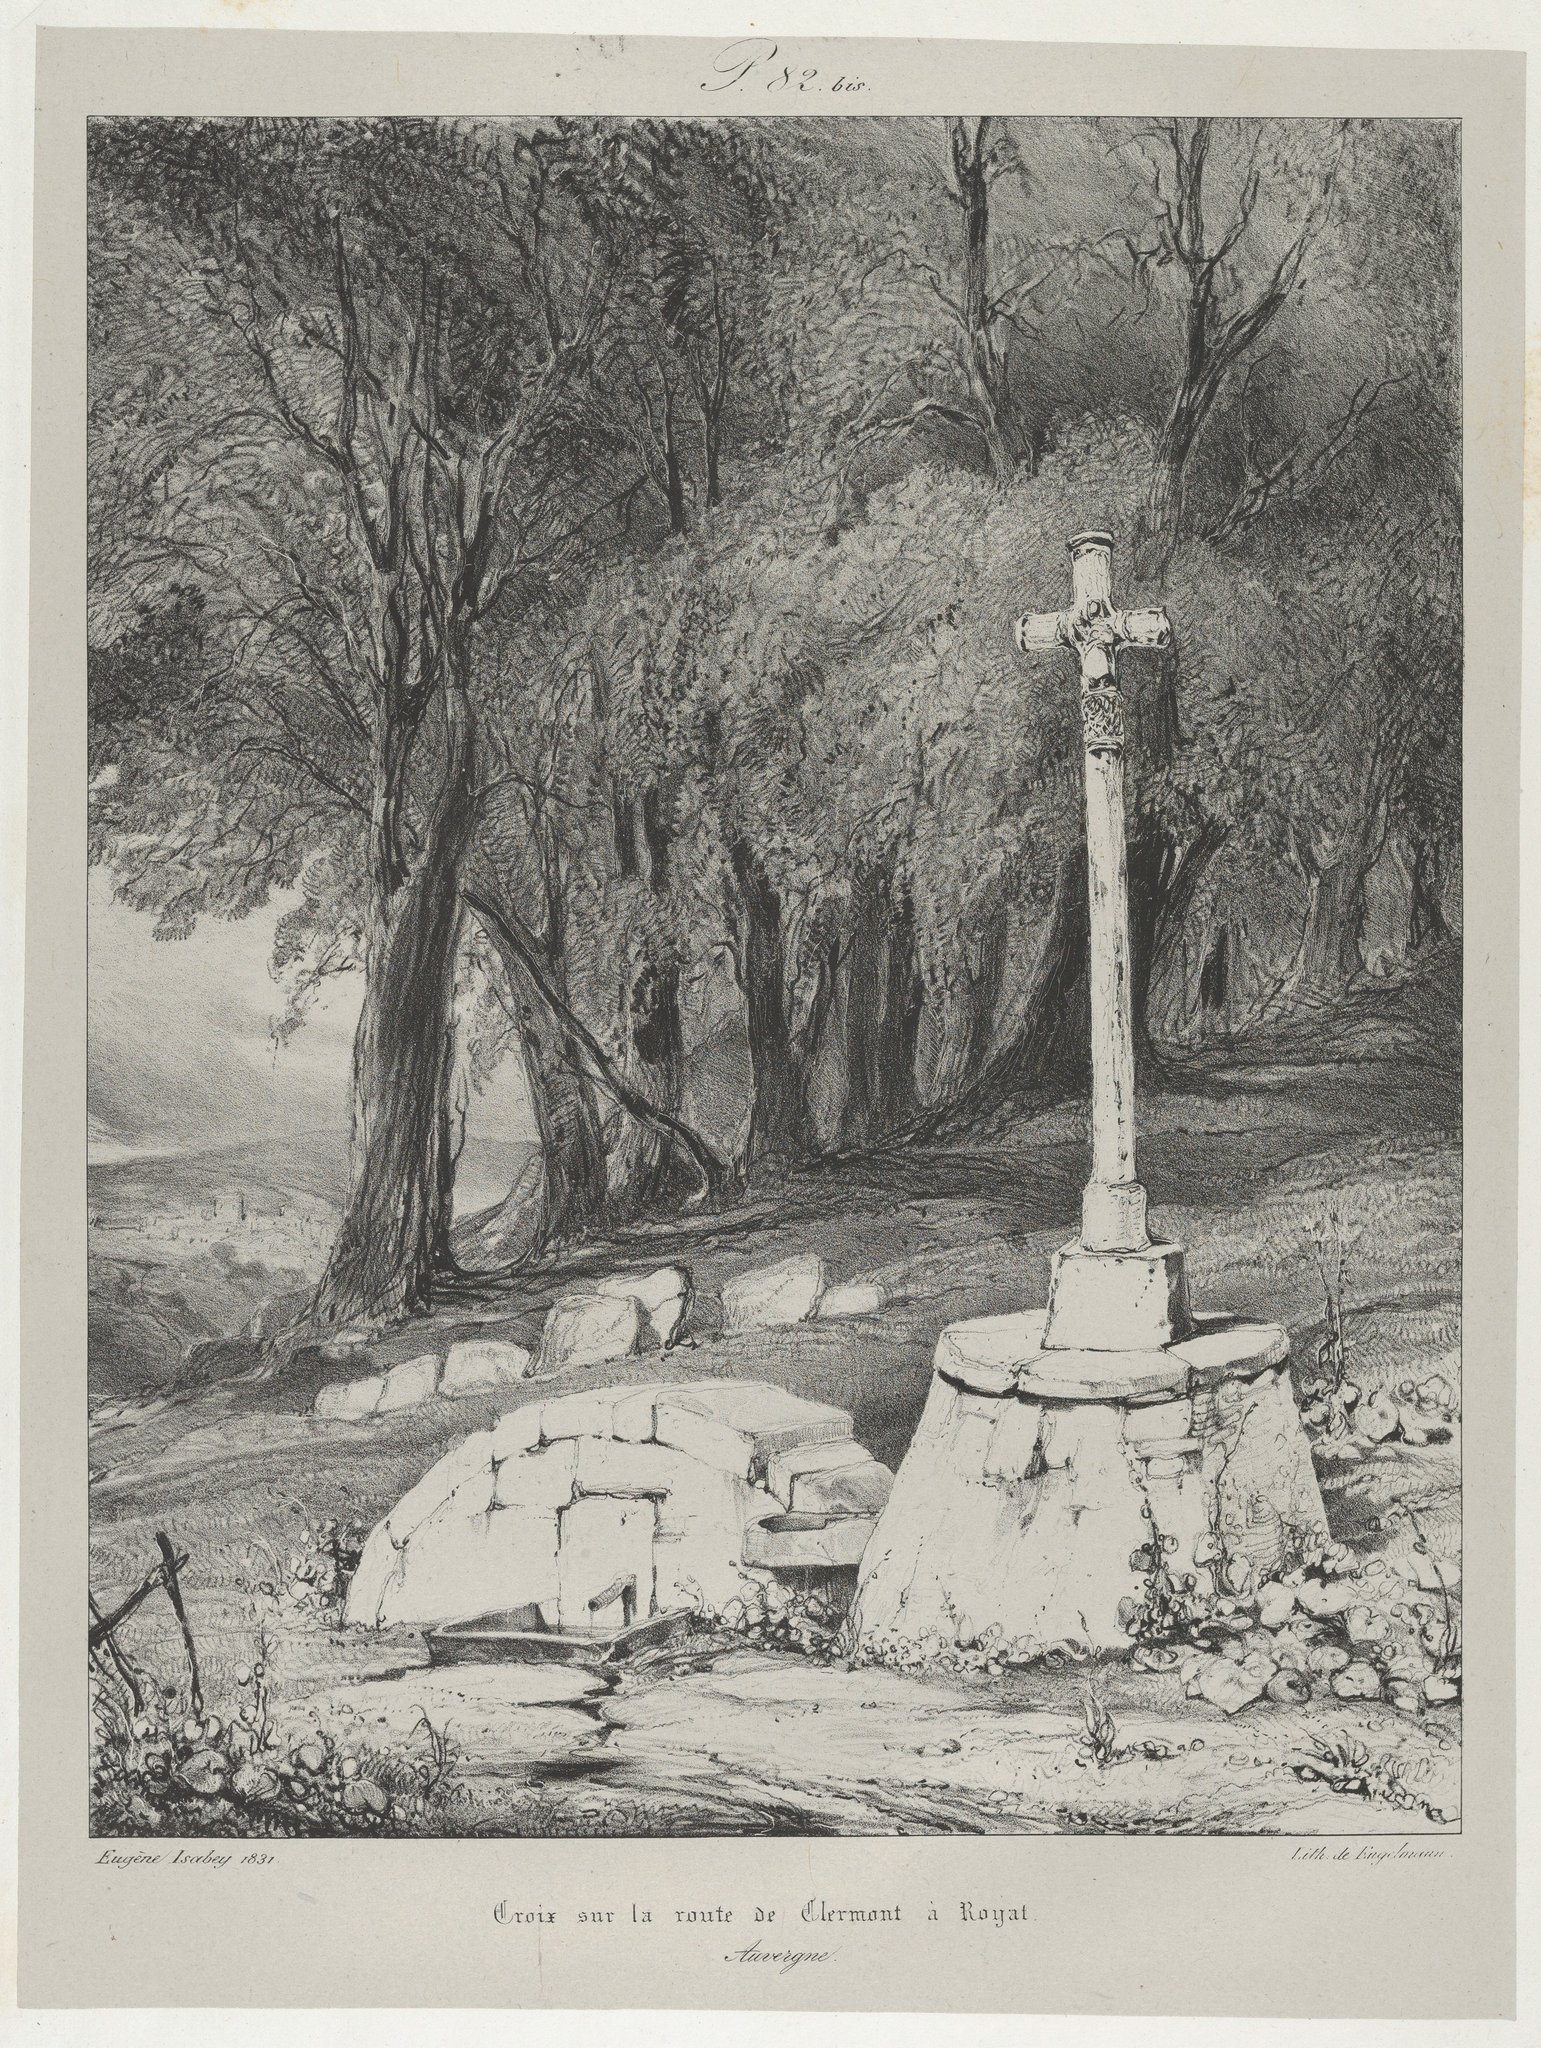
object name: print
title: Cross on the Route from Clermont to Royal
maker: eugène isabey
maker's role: artist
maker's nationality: french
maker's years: 1803-1886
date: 1831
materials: paper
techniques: printmaking, lithograph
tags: cross